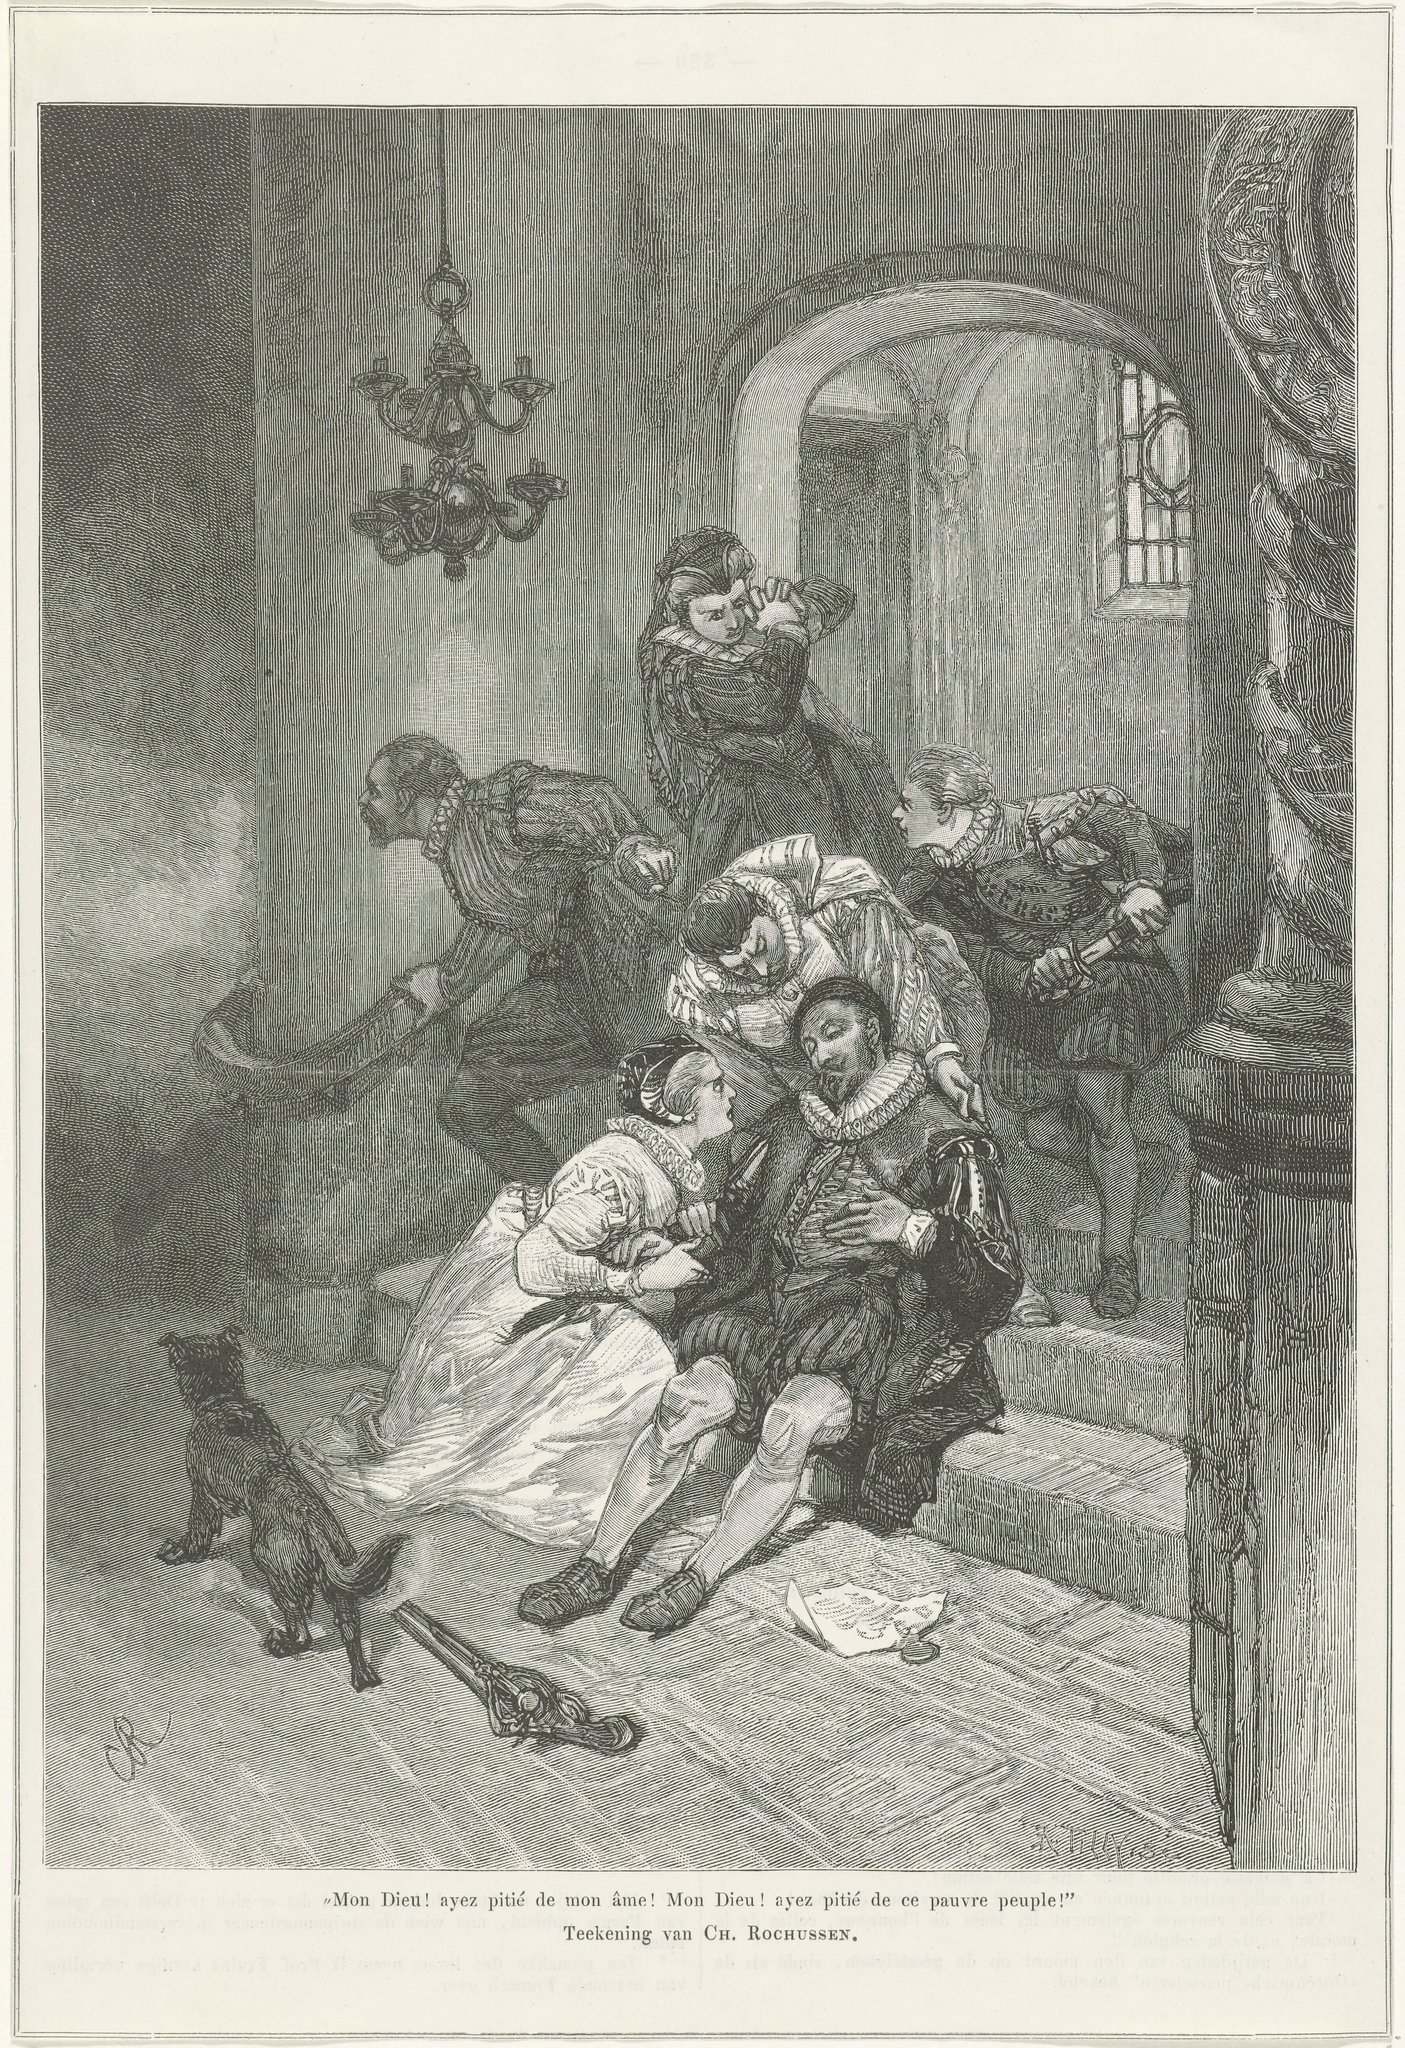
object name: history print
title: Moord op Willem van Oranje, 1584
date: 1824-1898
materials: paper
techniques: engraving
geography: netherlands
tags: delft, louise de coligny, william i (prince of orange), attempt, political murder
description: De prins van Oranje te Delft vermoord door Balthasar Gerards, 10 juli 1584. Willem van Oranje zit onderaan de trap, zijn vrouw knielt aan zijn zij, links is nog net de voet van de vluchtende dader te zien. In het onderschrift de laatste woorden van prins: Mon Dieu! ayez pitié de mon âme! Mon Dieu! ayez pitié de ce pauvre peuple! Bedrukt op achterzijde met tekst in het Nederlands.